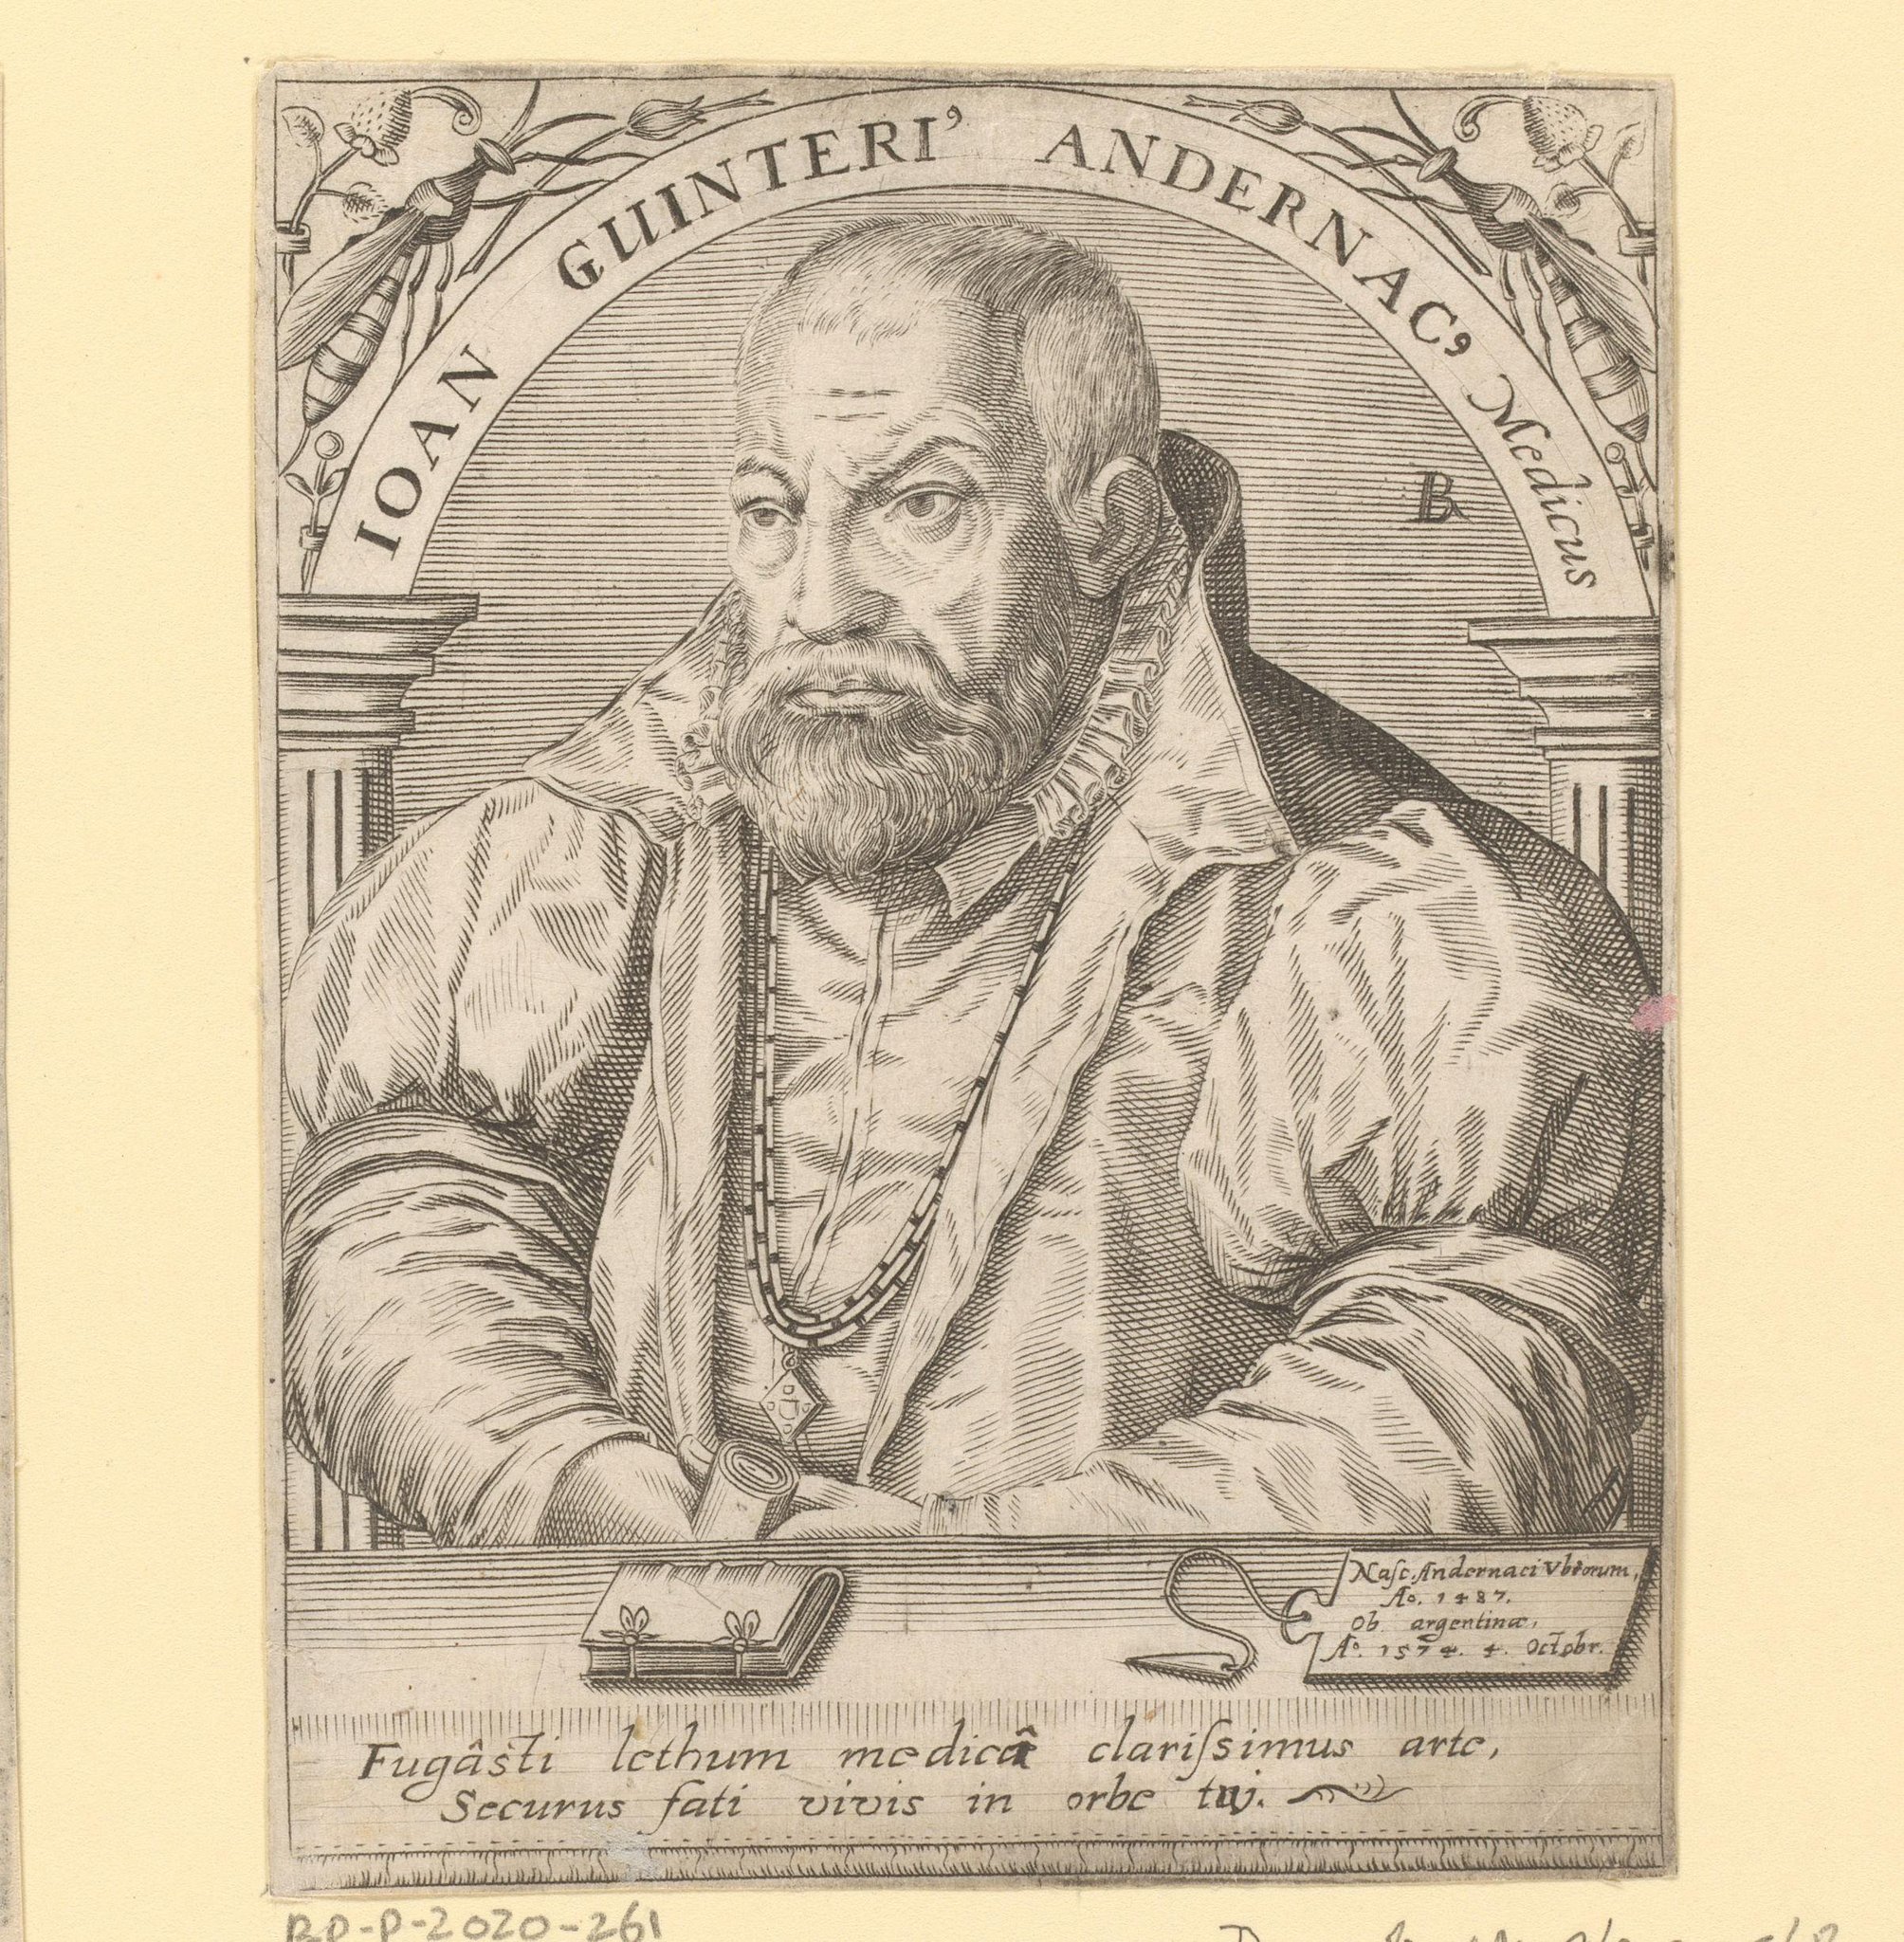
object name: print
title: Ioan Guinteri[9] Andernac[9] medicus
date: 1599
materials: paper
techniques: engraving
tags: historical persons, physician, doctor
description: Prent gebruikt in: Boissard, Jean Jacques. Icones quinquaginta virorum illustrium doctrina & eruditione praestantium ad vivum effictae. 4 dln. Frankfurt am Main: s.n., 1597-1599. Mogelijk ook gebruikt in latere edities. Latere staat van prent verschenen in: Boissard, Jean Jacques. Bibliotheca chalcographica. 8 dln. Frankfurt am Main: Johannes Ammon, 1650-1652. Ook gebruikt in latere edities.